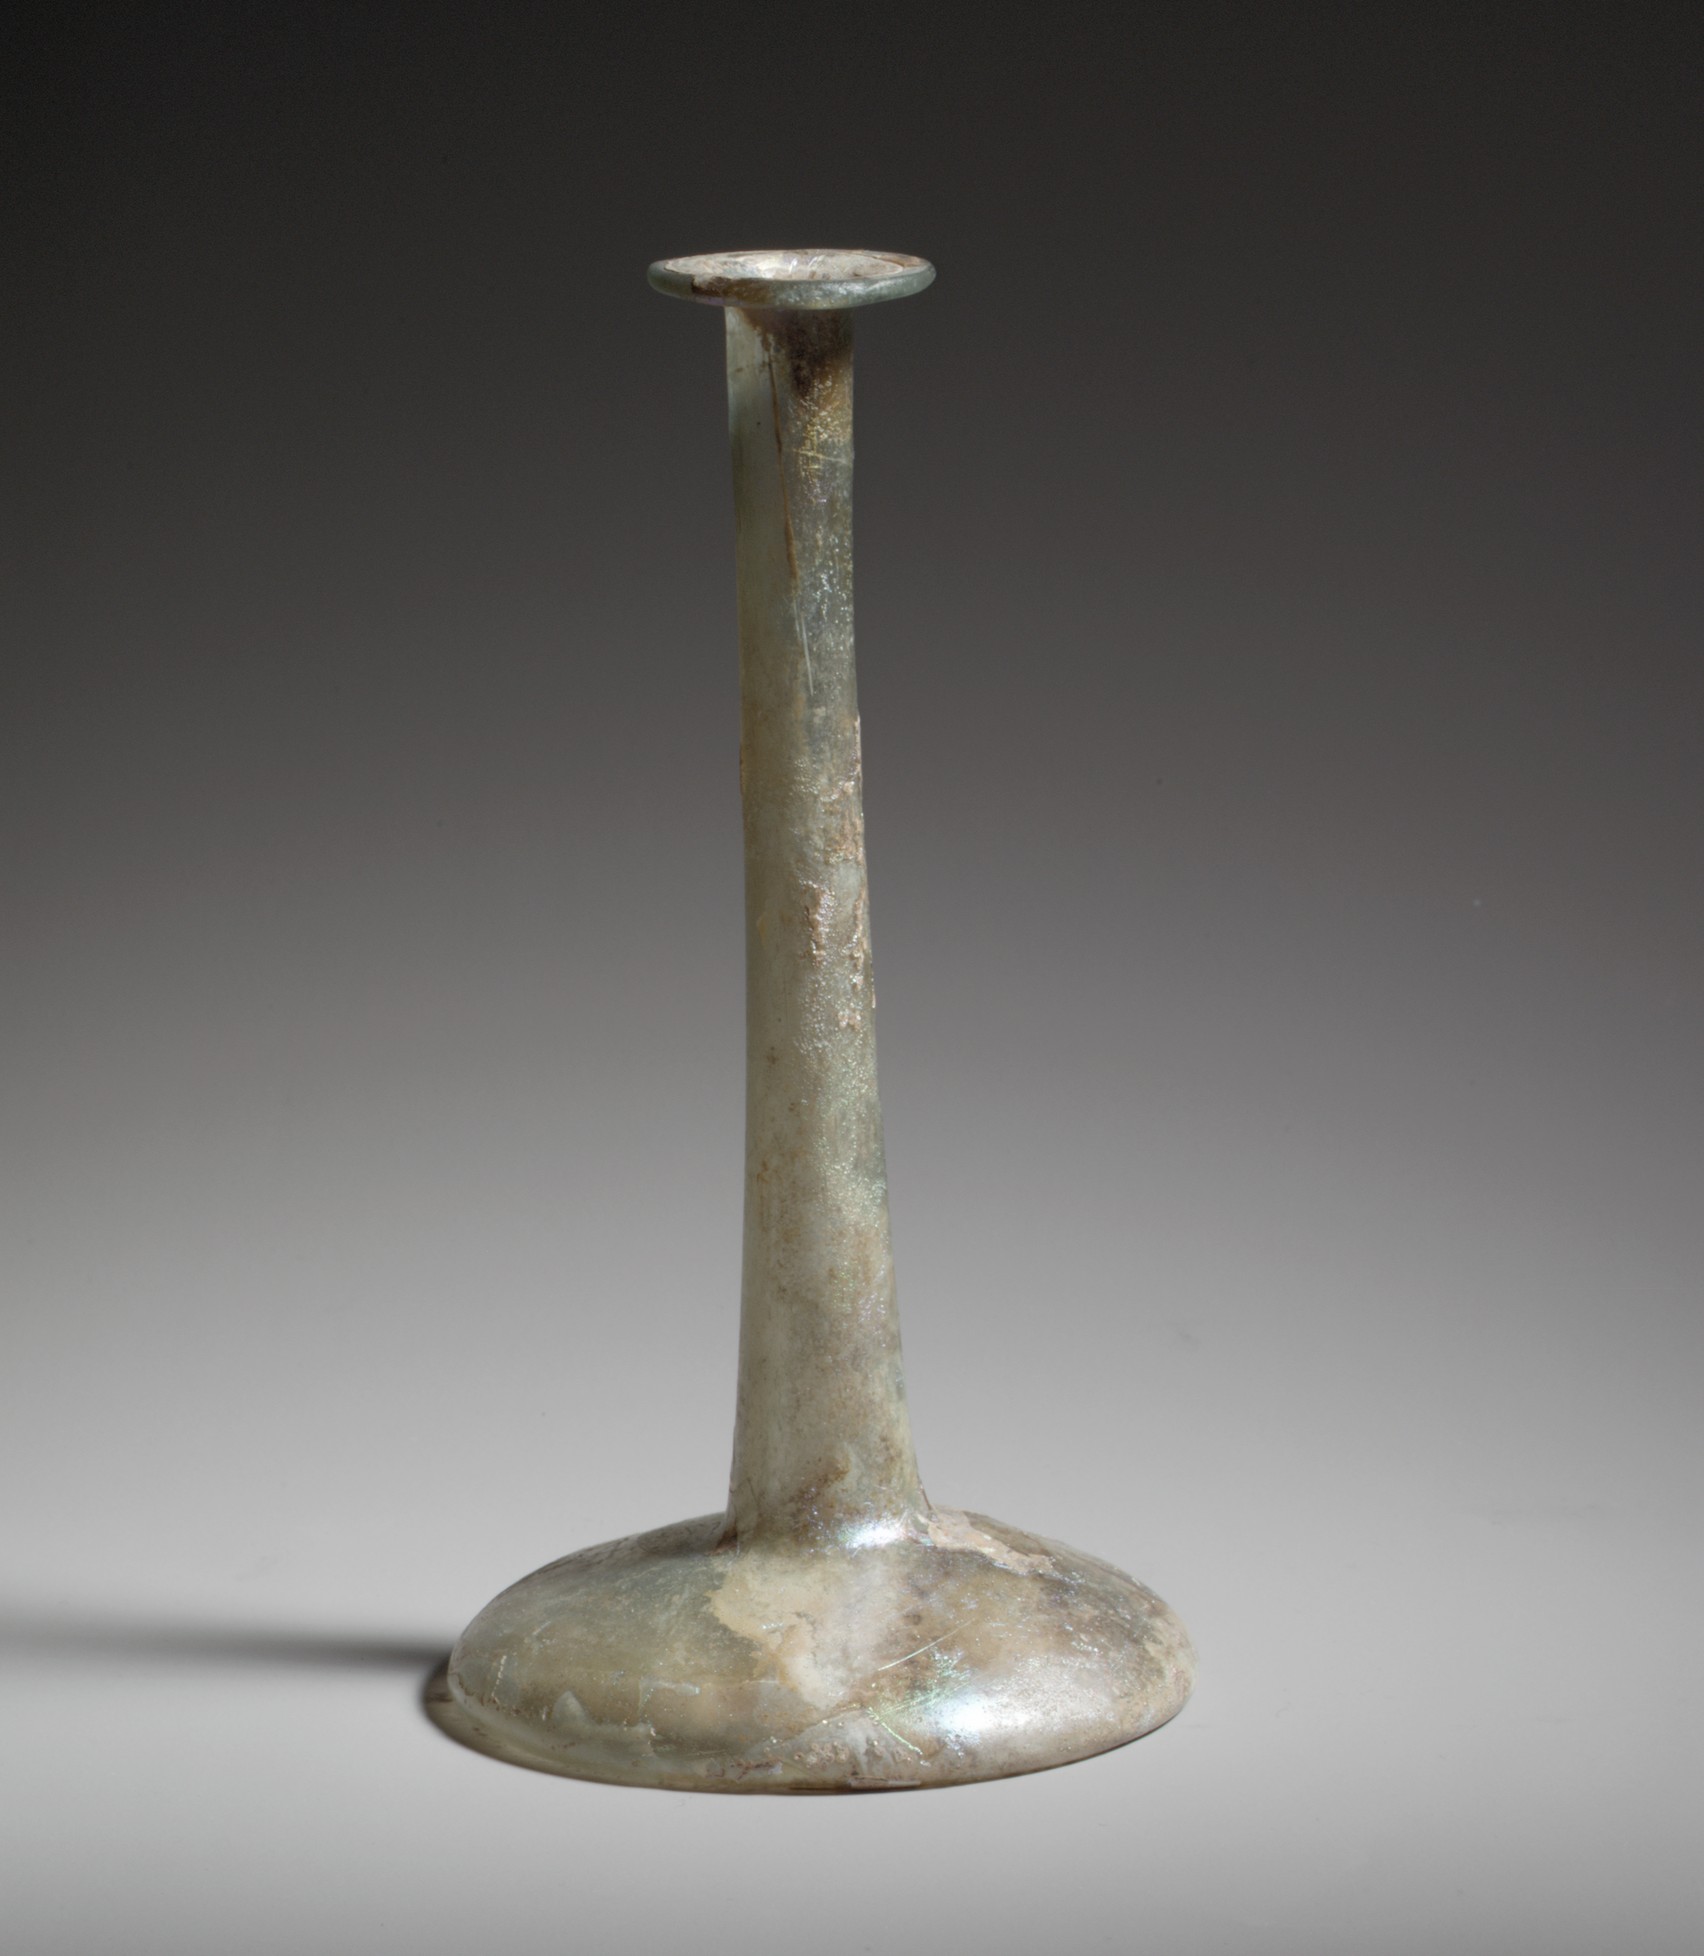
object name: candlestick perfume bottle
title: Glass perfume bottle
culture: roman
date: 101-300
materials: glass